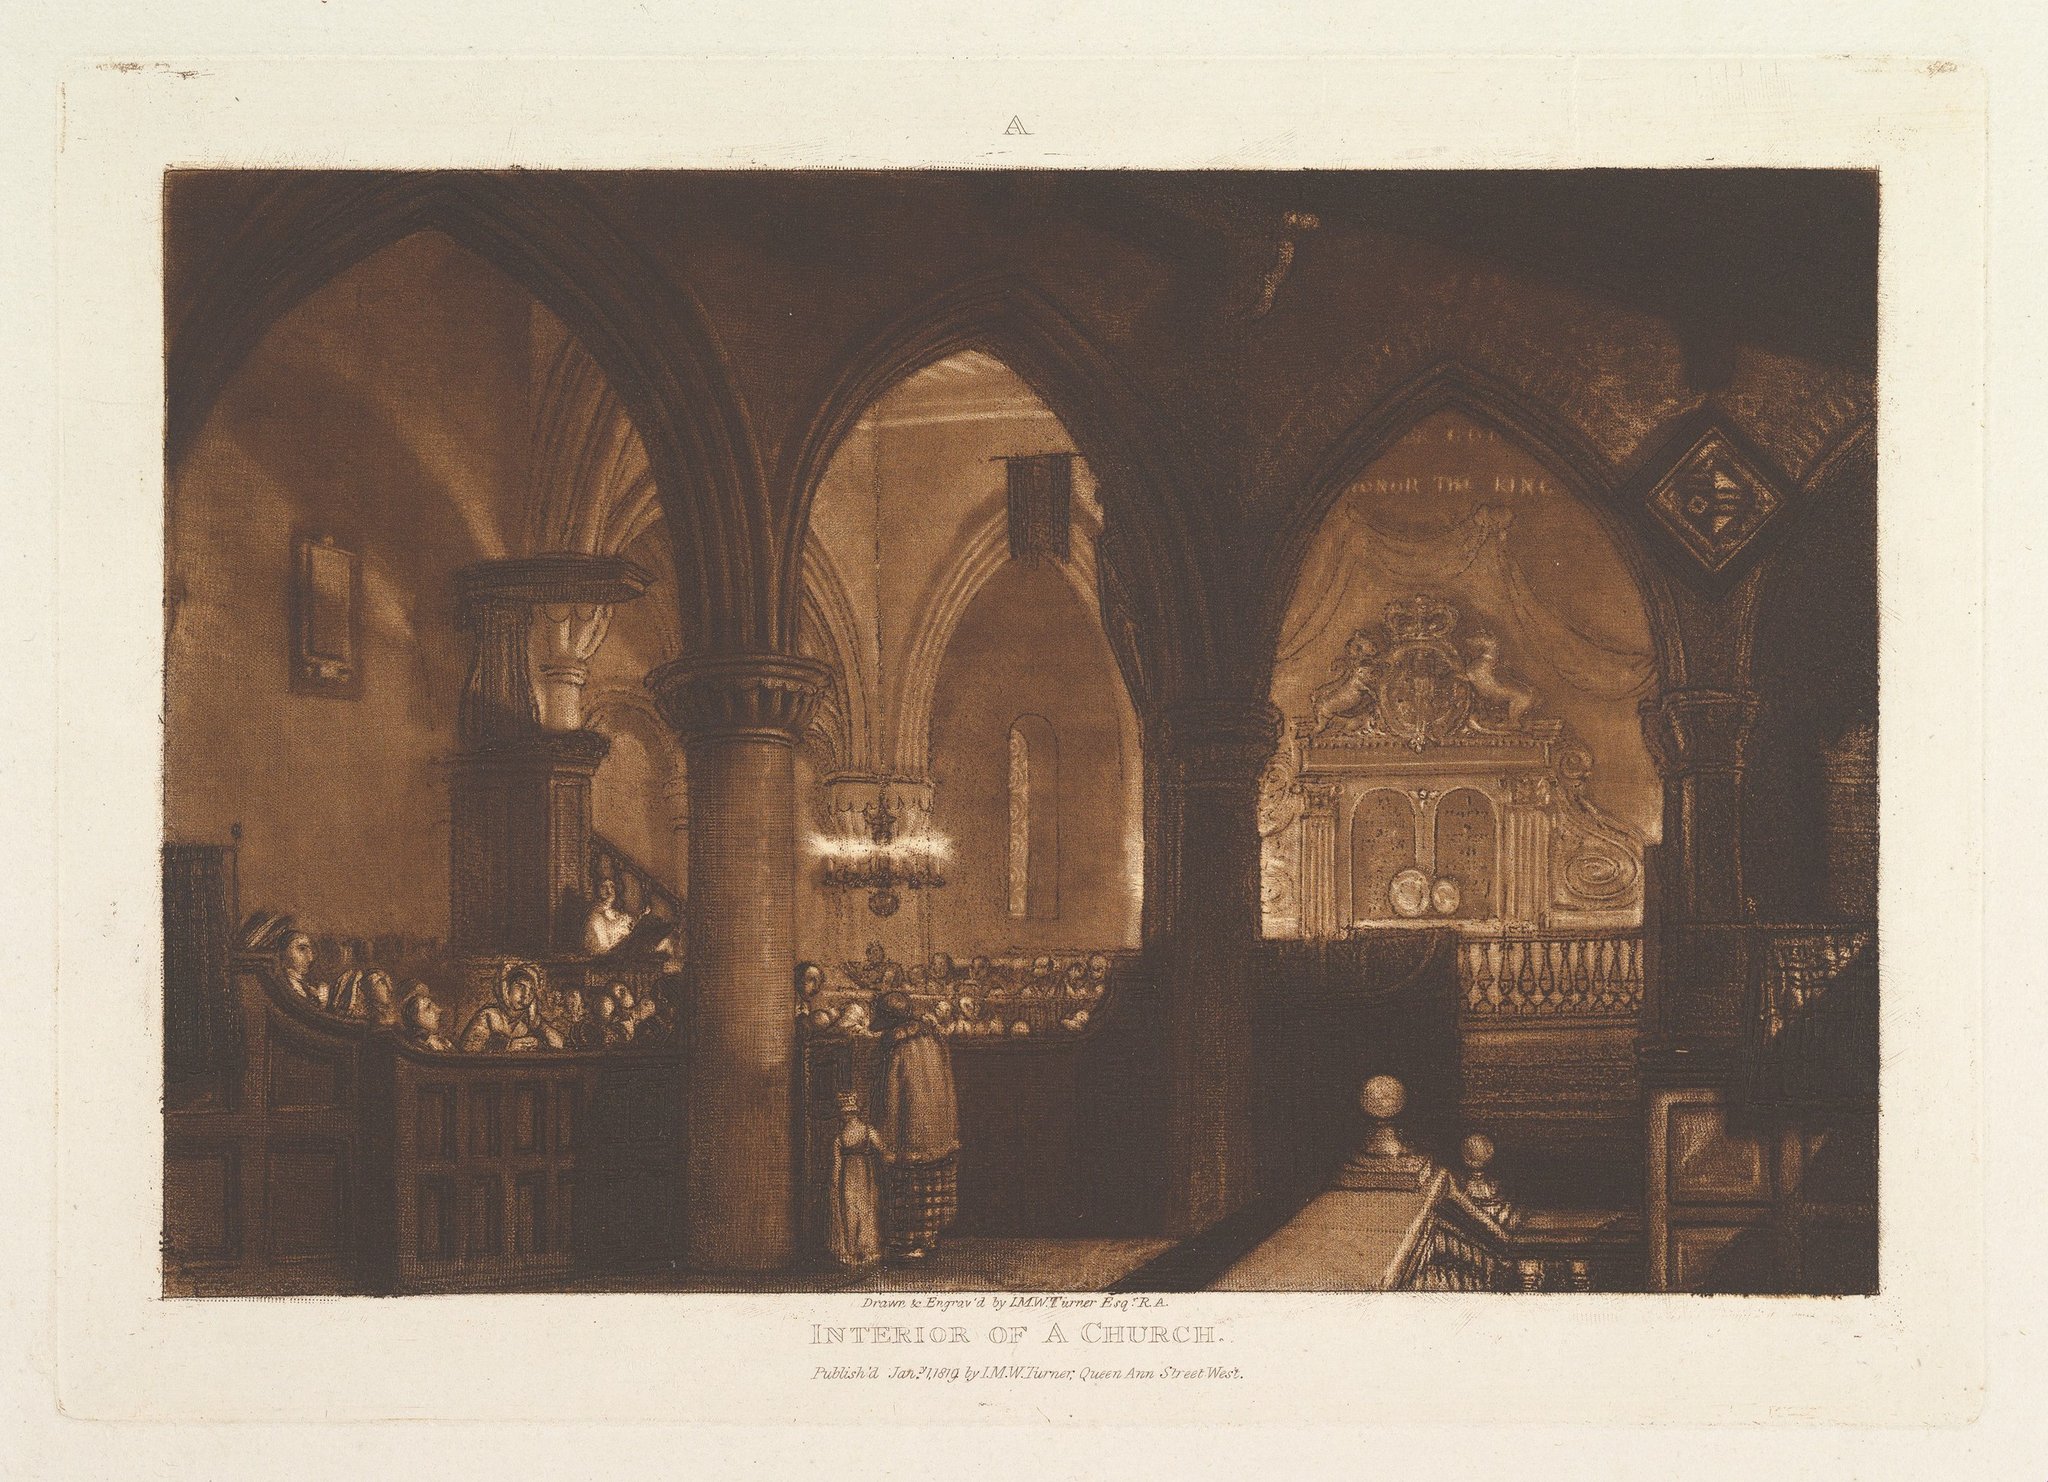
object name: print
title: Interior of a Church, part XIV, plate 70 from "Liber Studiorum"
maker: joseph mallord william turner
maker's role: artist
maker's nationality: british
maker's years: 1775-1851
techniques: etching, mezzotint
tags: human figures,interiors,churches